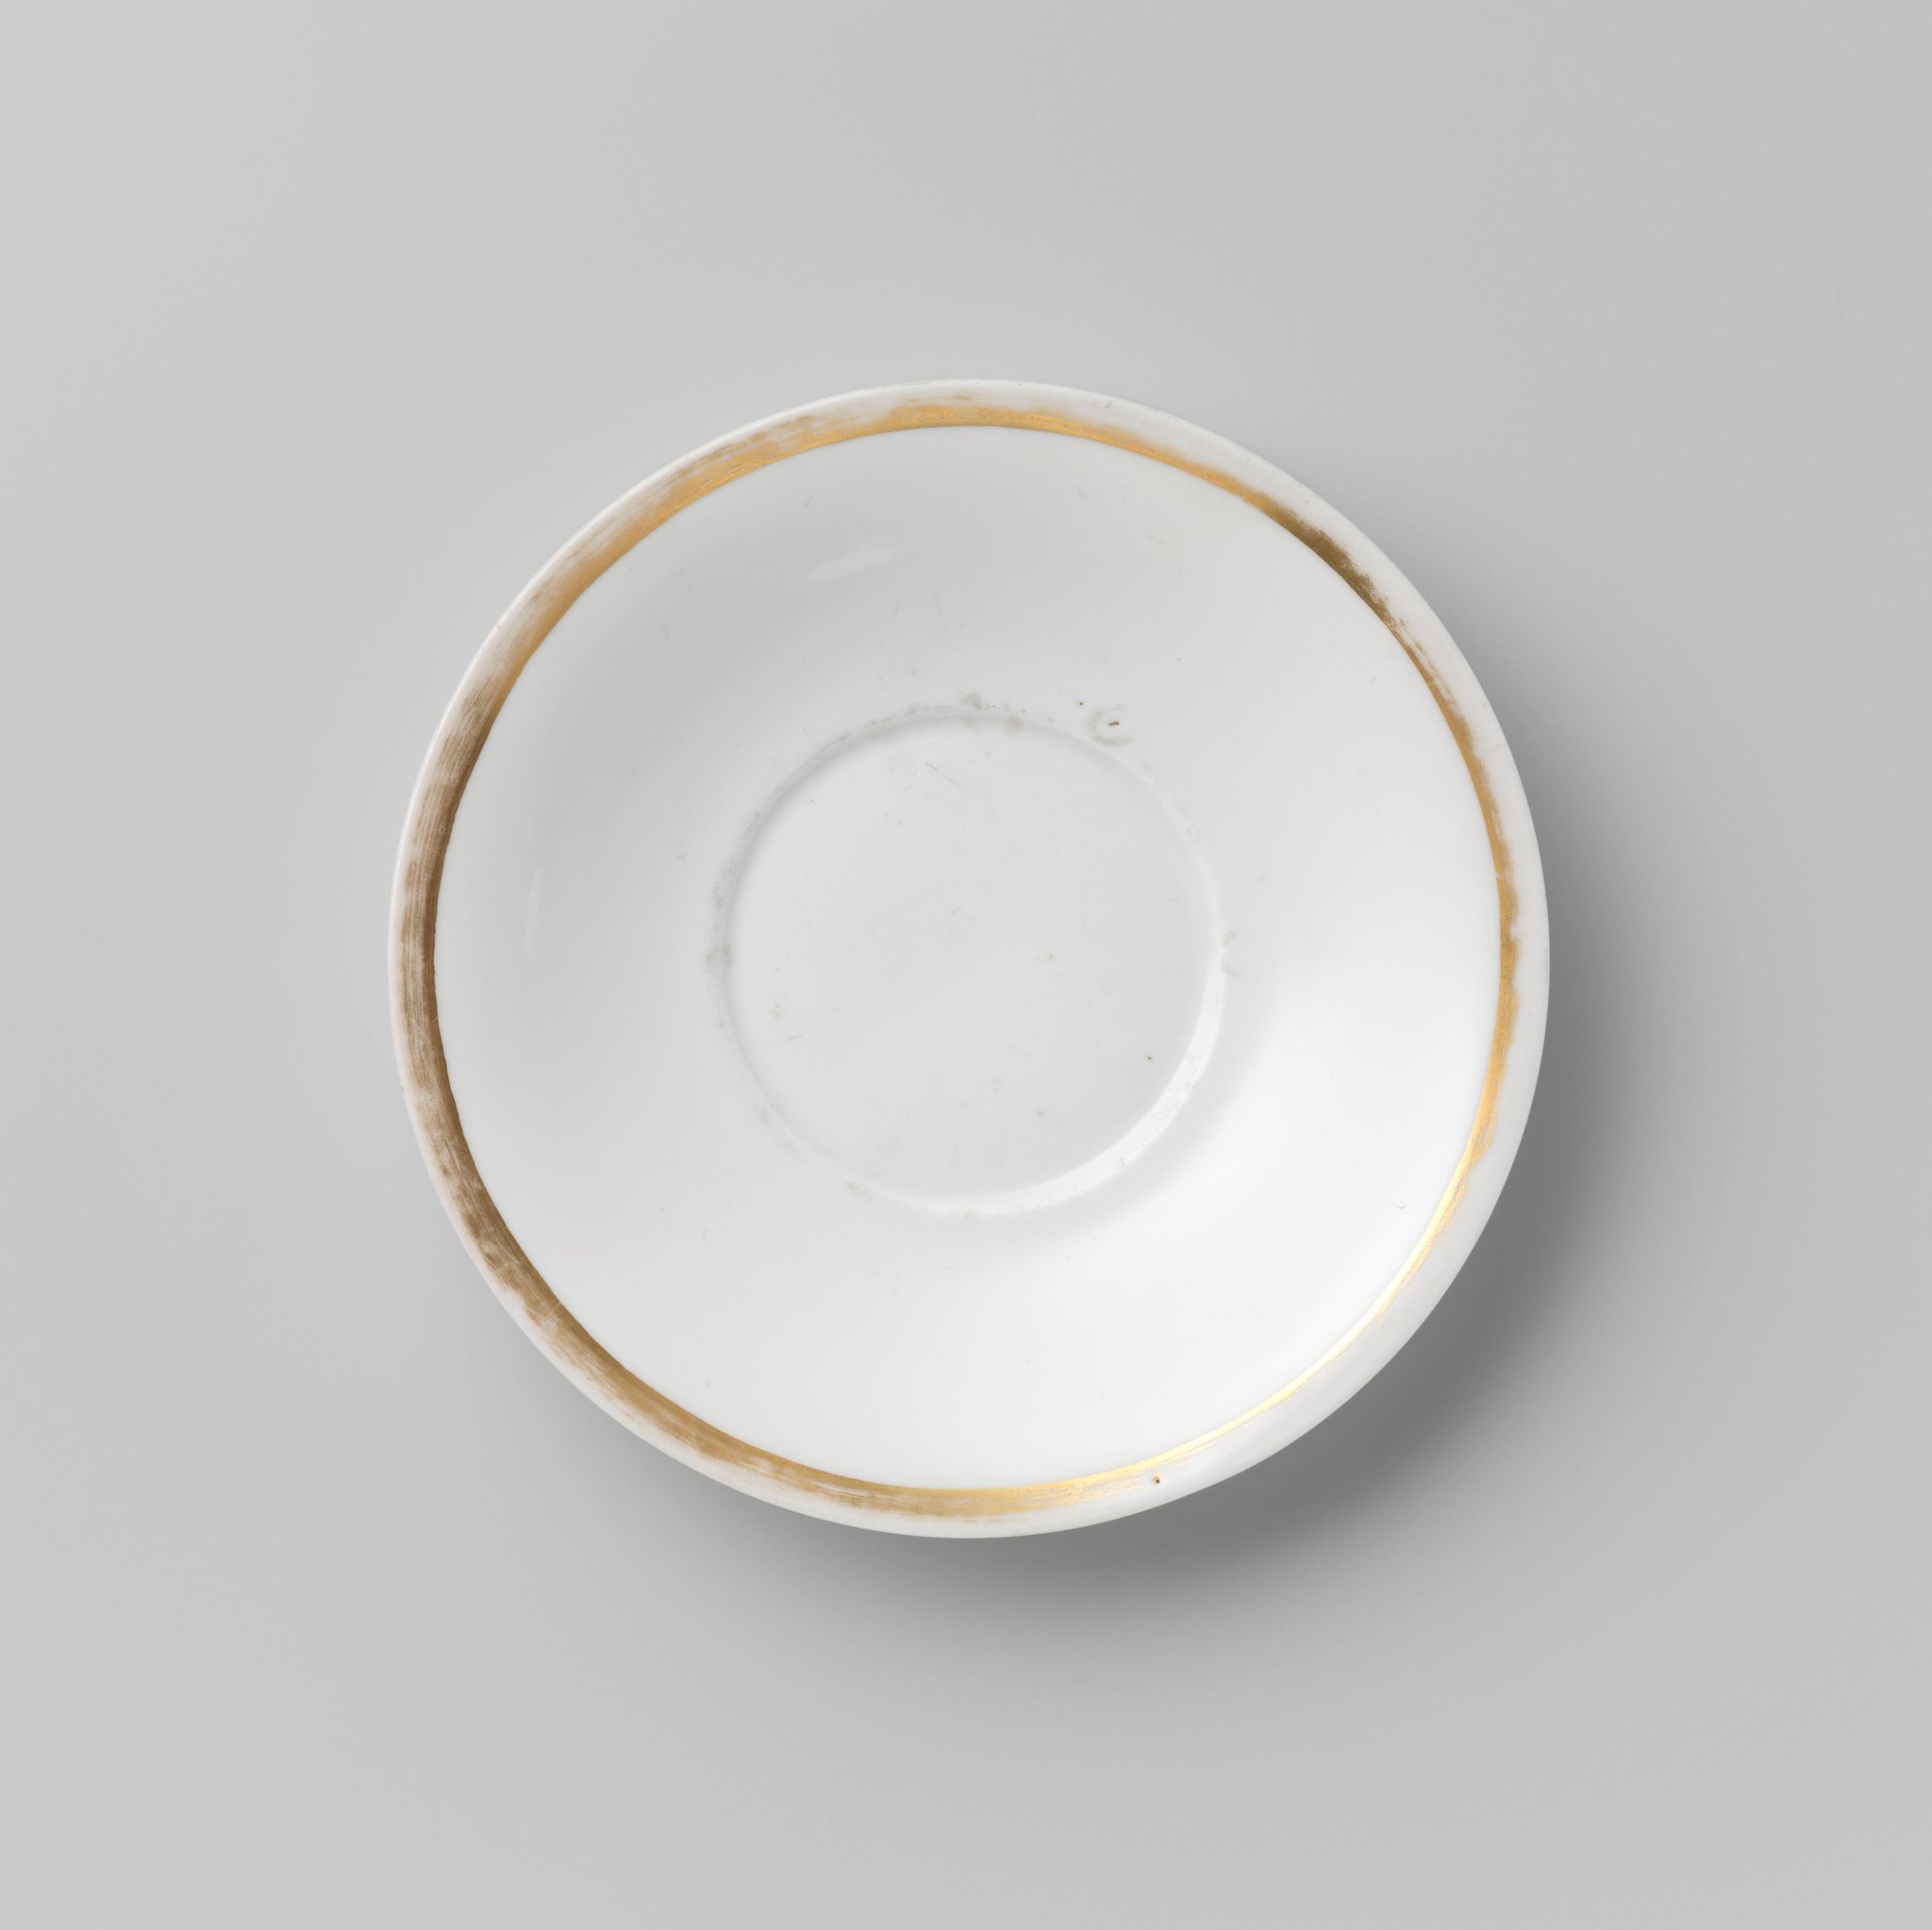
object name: platter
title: Saucer with a golden edge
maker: Anonymous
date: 1800-1810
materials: glaze, gold, paint, porcelain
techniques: firing, forming, gilding, turning, vitrification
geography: europe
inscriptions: mark: ‘74’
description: Schotel van soft-paste porselein (pâte tendre), beschilderd op het glazuur in goud. Gouden rand. Gemerkt op de onderzijde met 74.